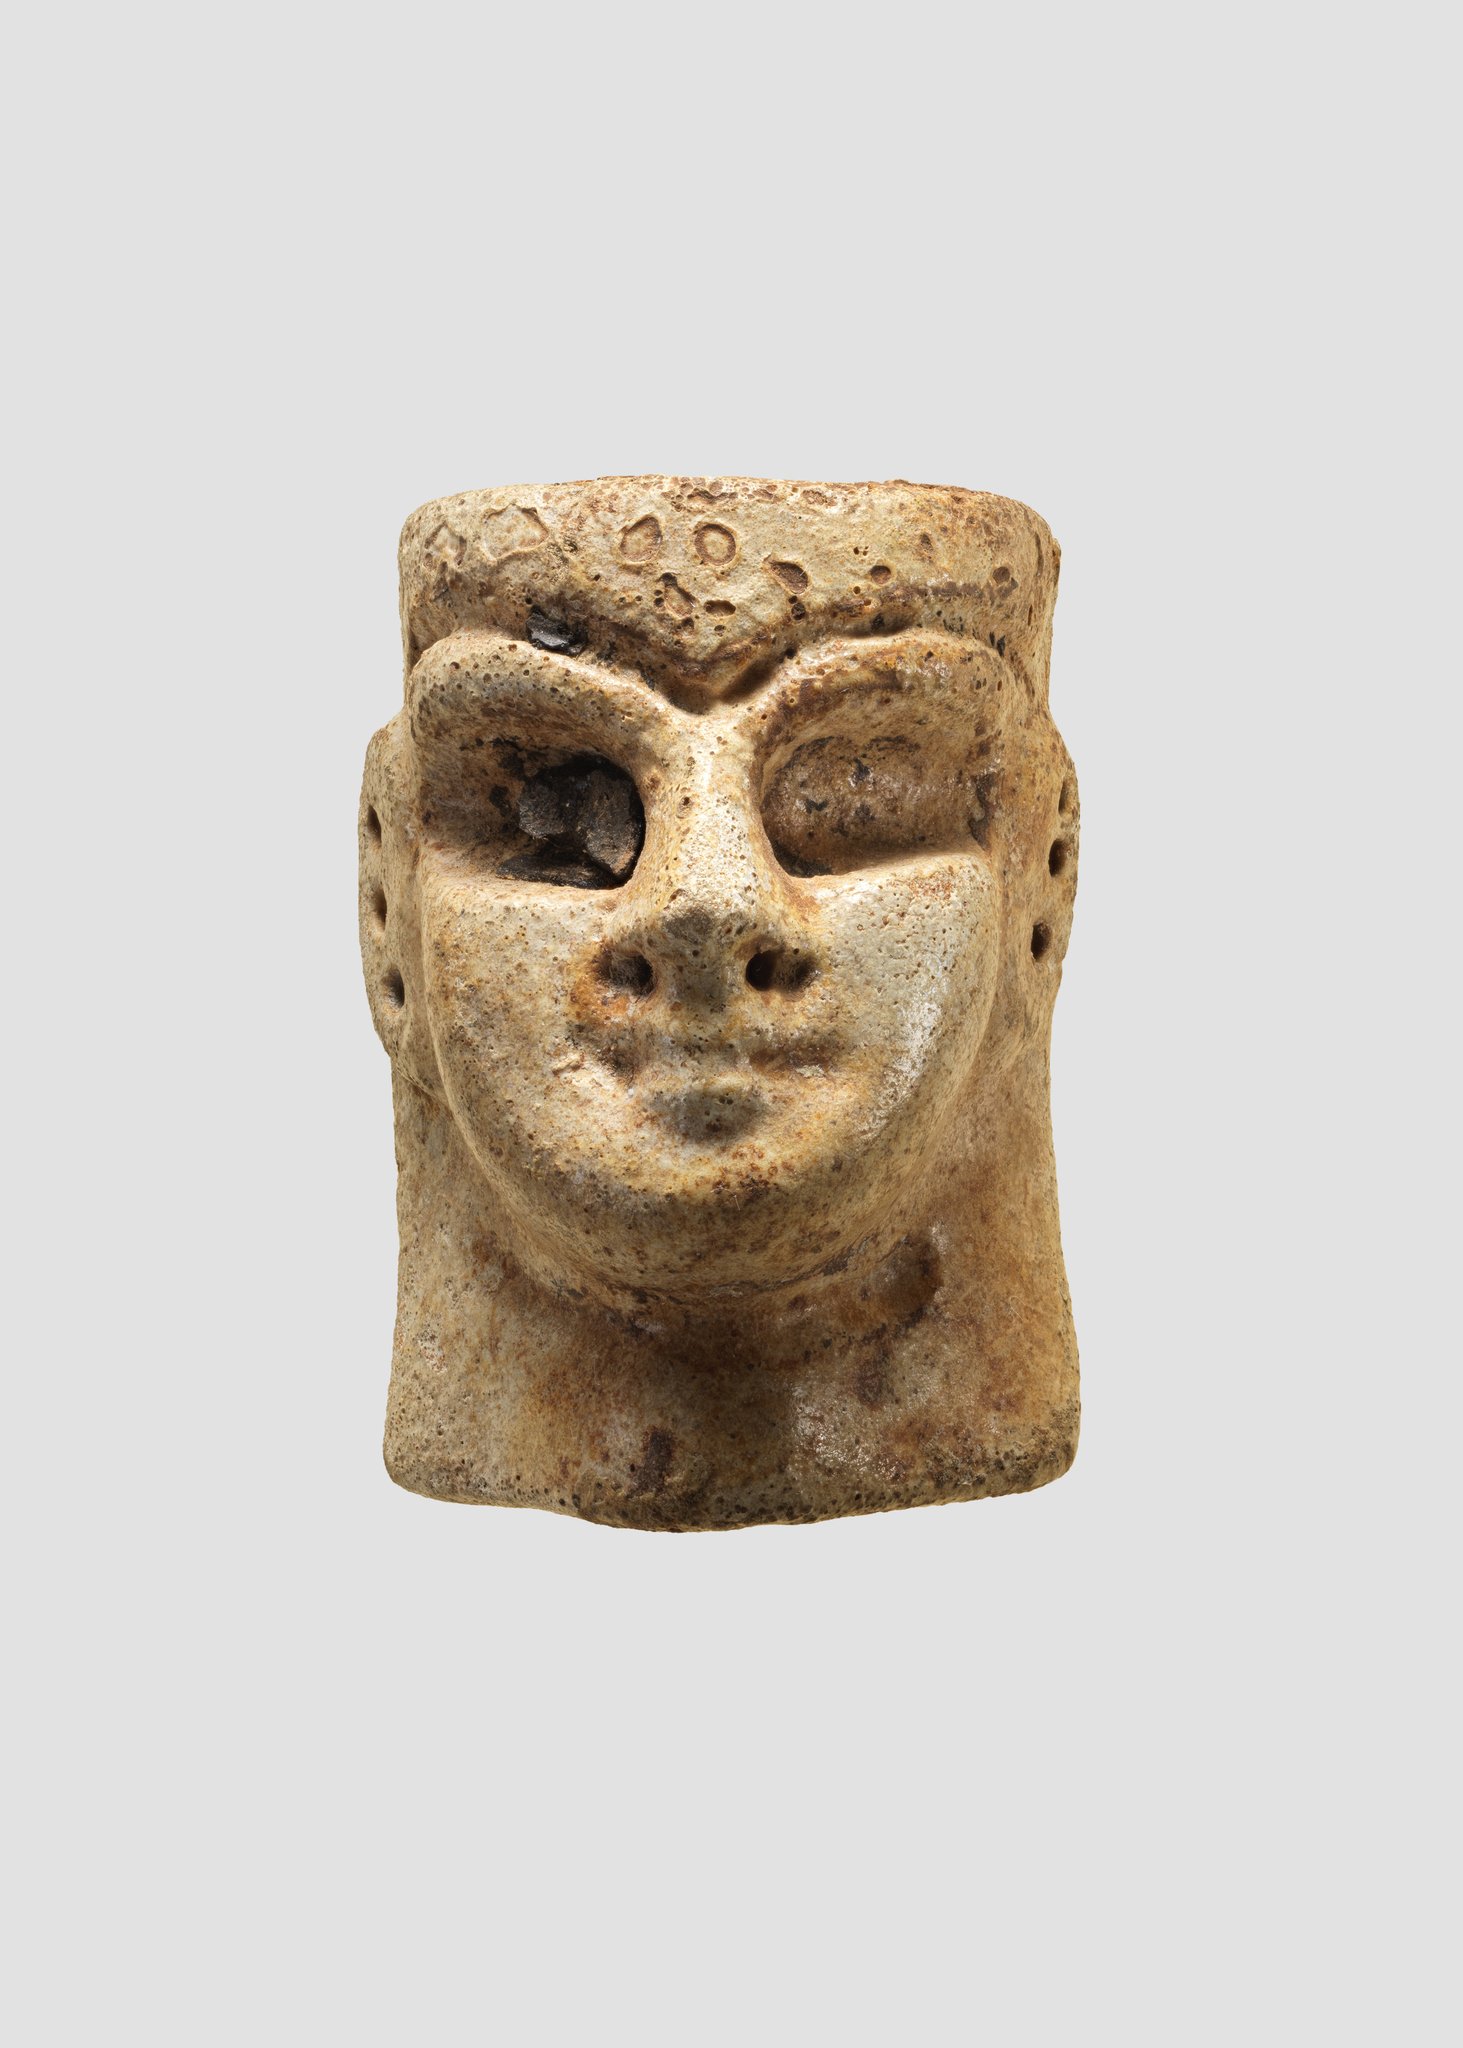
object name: sculpture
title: Head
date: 1400-1201 BCE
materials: faience, glaze, paint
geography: mesopotamia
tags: heads